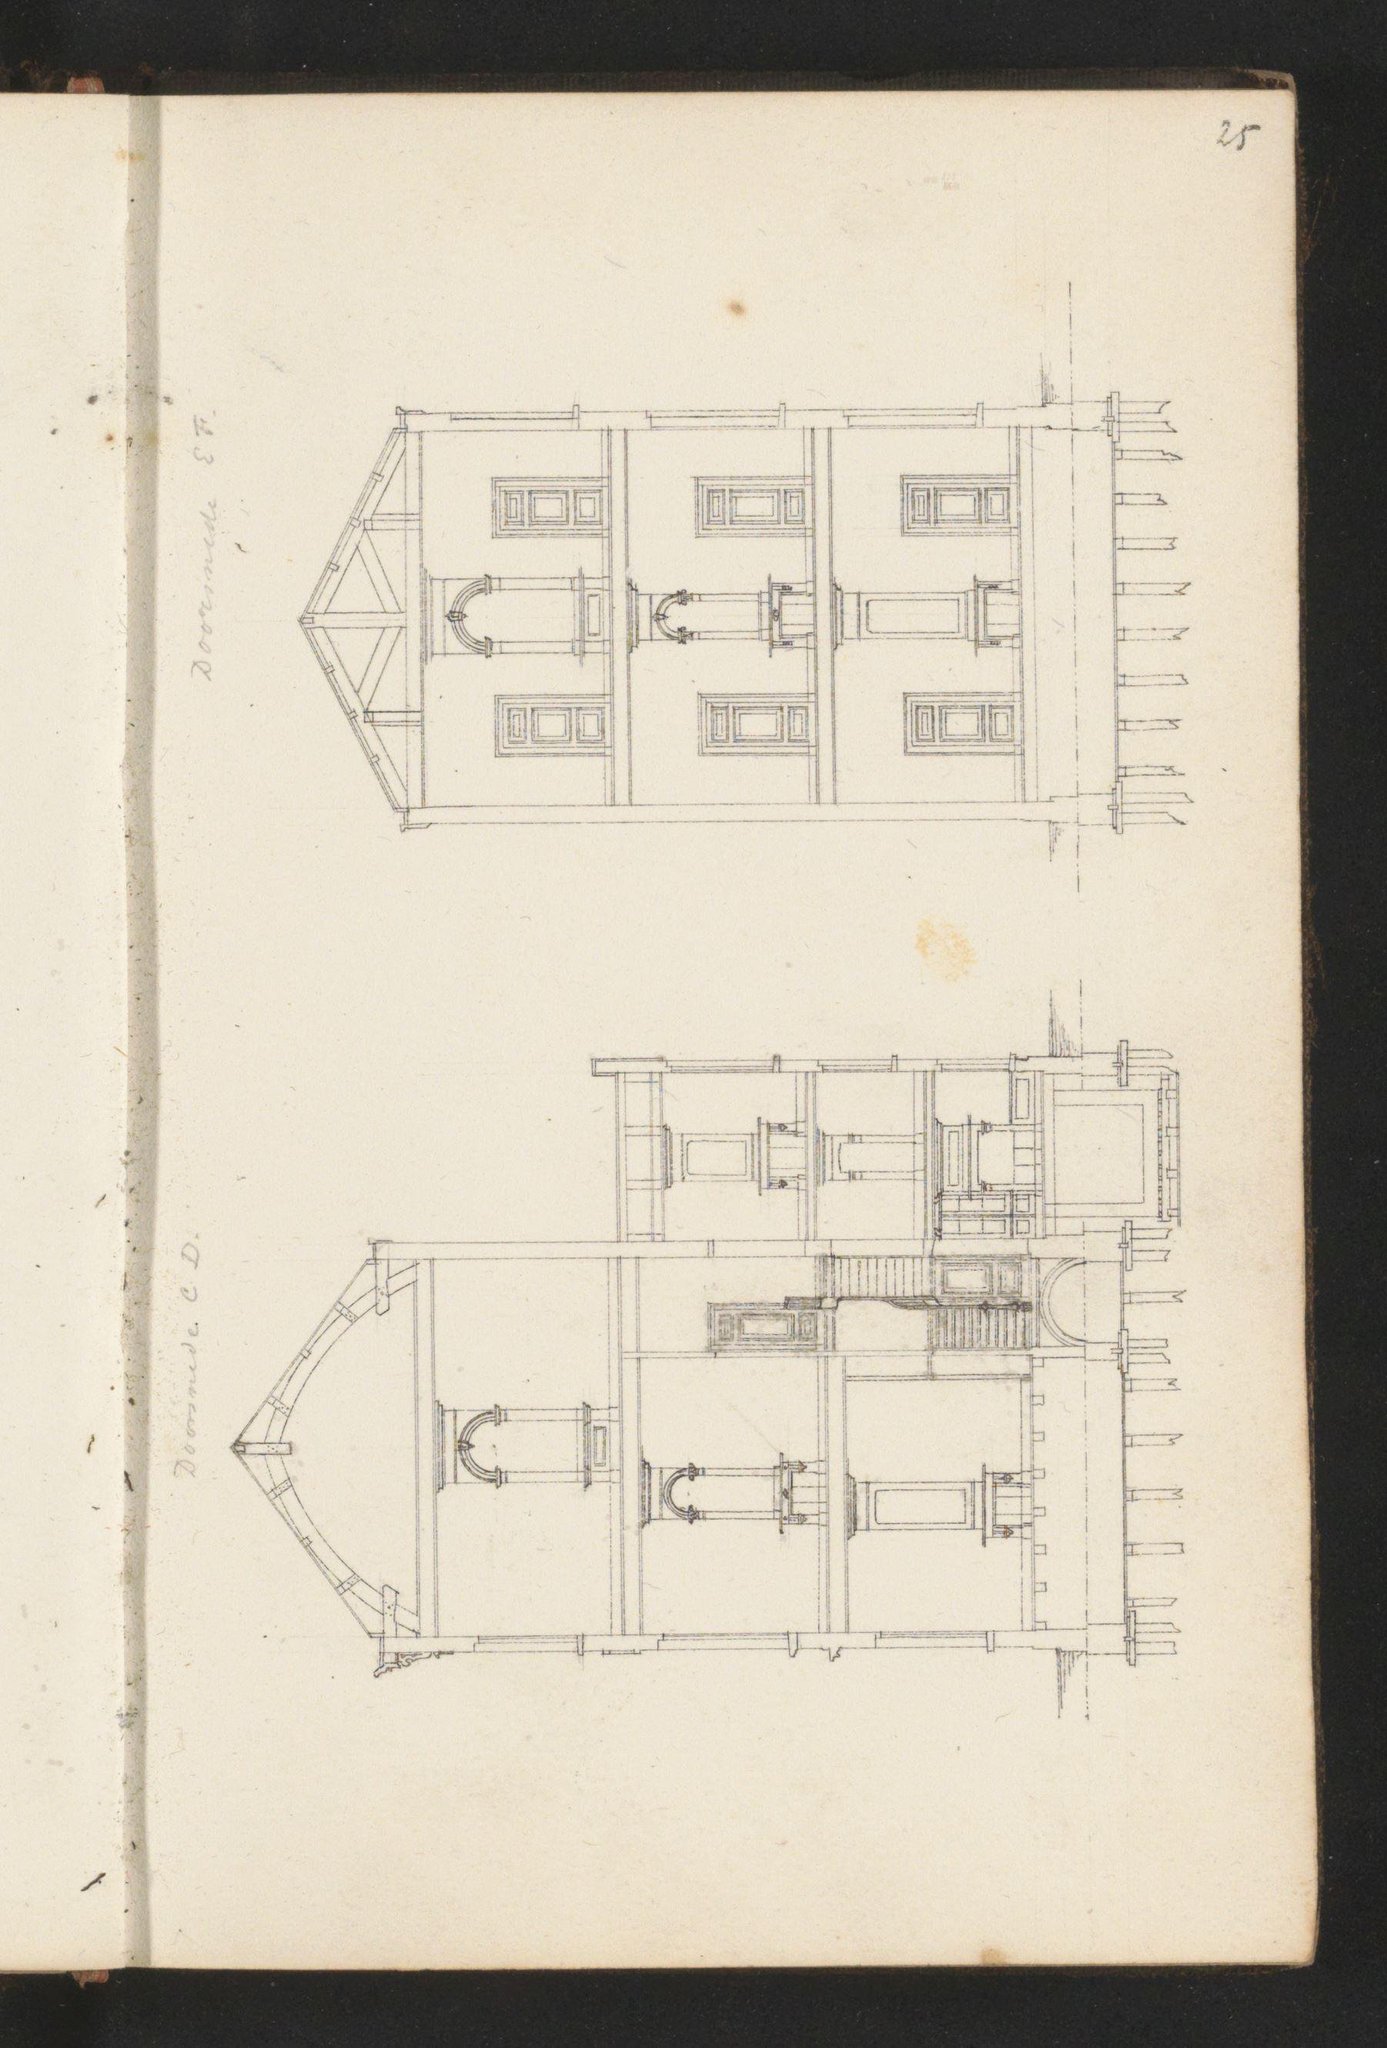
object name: sketchbook leaf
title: Doorsneden van twee huizen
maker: willem springer jr.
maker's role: draughtsman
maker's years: 1815-1907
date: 1864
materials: ink, paper, pencil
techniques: pen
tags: section ~ architectural design or model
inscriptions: annotation: ‘Doorsnede C.D./ Doorsnede E F’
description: Pagina 25 uit een schetsboek met 164 pagina's.